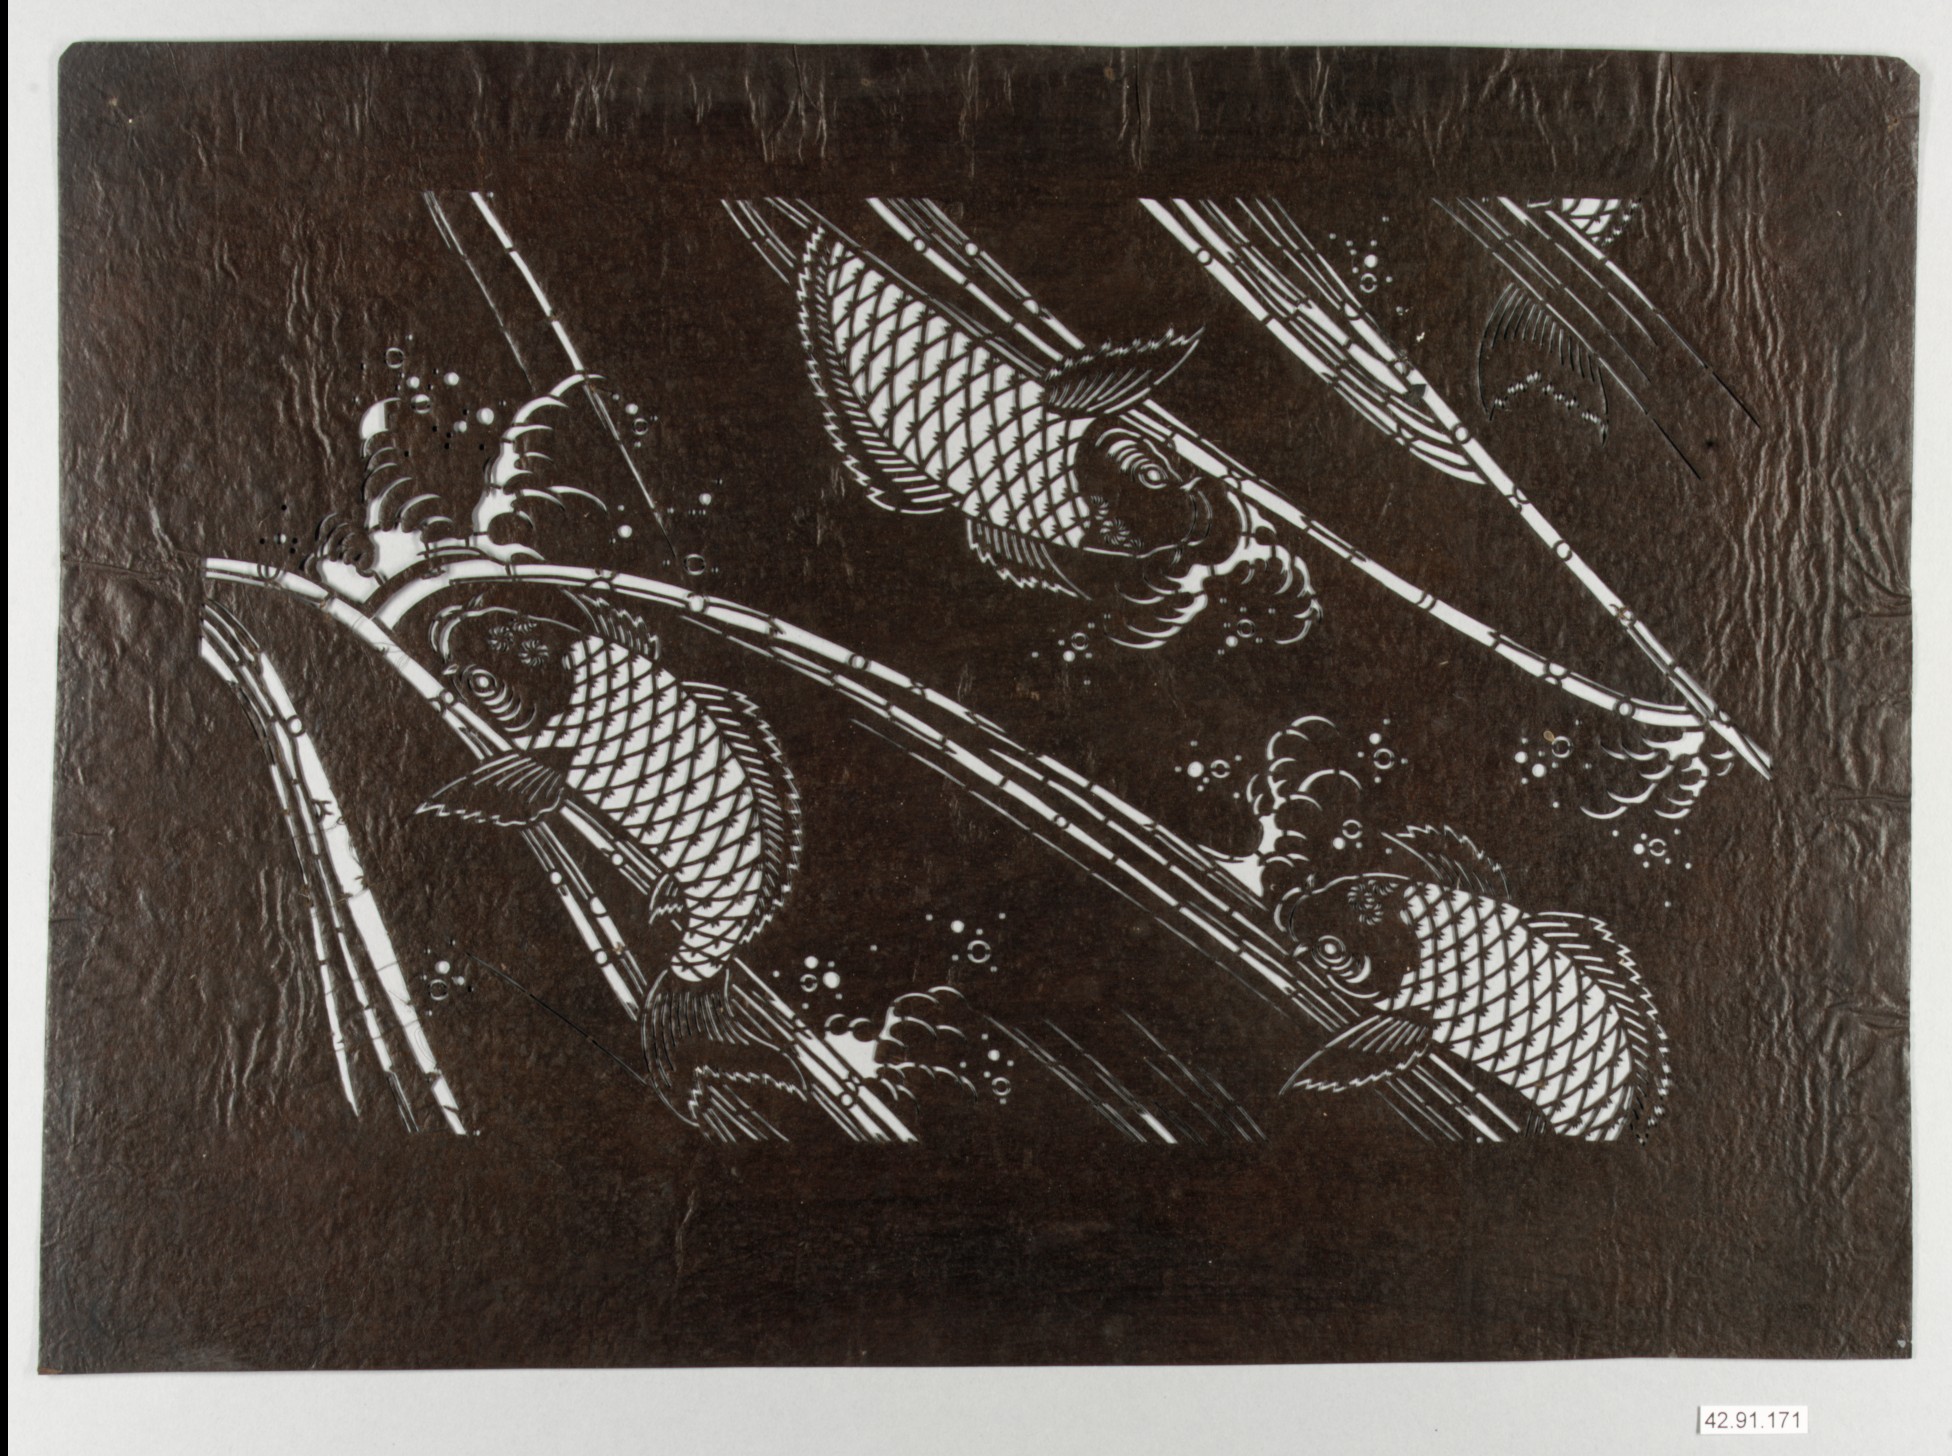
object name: stencil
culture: japanese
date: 1801-1900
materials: paper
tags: fish